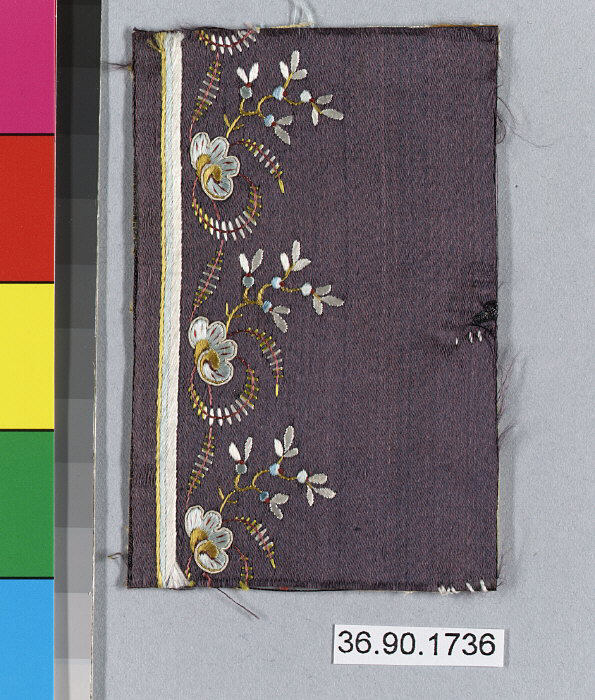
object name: sample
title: Embroidery sample for a man’s suit or waistcoat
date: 1785-1815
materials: silk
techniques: embroidery